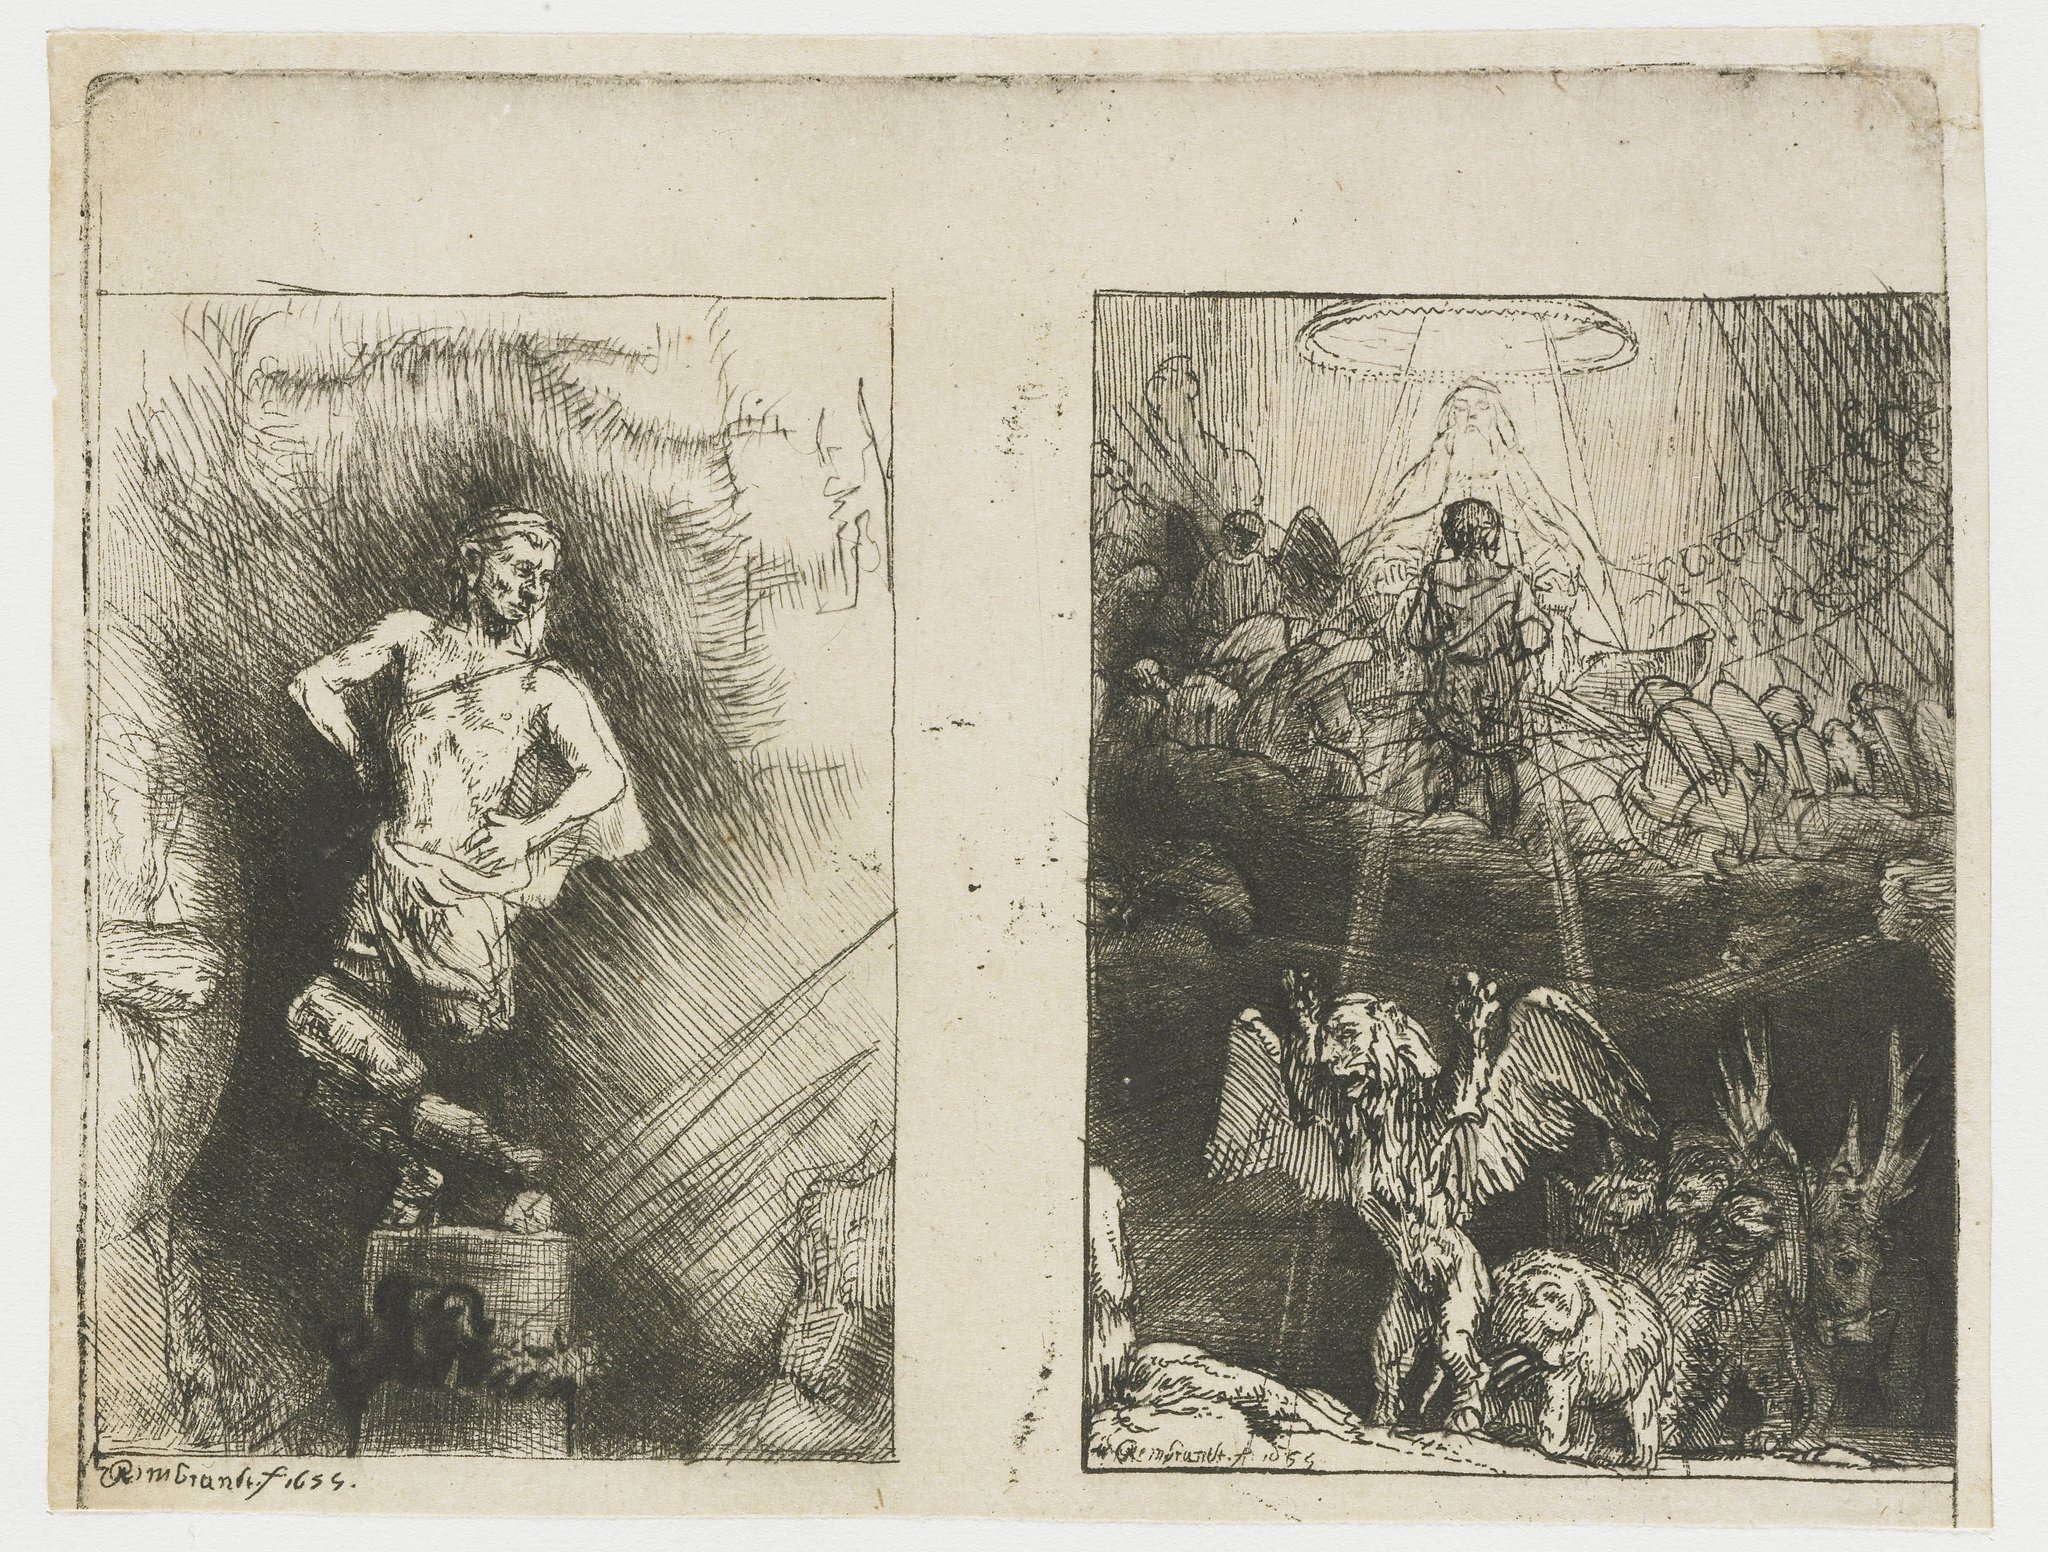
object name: print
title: Two illustrations to Menasseh Ben Israel's 'Piedra Gloriosa'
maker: rembrandt van rijn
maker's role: draughtsman, painter, print maker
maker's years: 1606-1669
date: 1655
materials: paper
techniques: drypoint, etching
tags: daniel's visions (daniel may be shown having his visions explained, e.g. by the archangel gabriel), king nebuchadnezzar dreams of a great statue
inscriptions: signature and date: ‘Rembrandt f 1655’, inscription: ‘1st state rariss. 6.6.0 - Tiffin’, mark: Lugt 2228